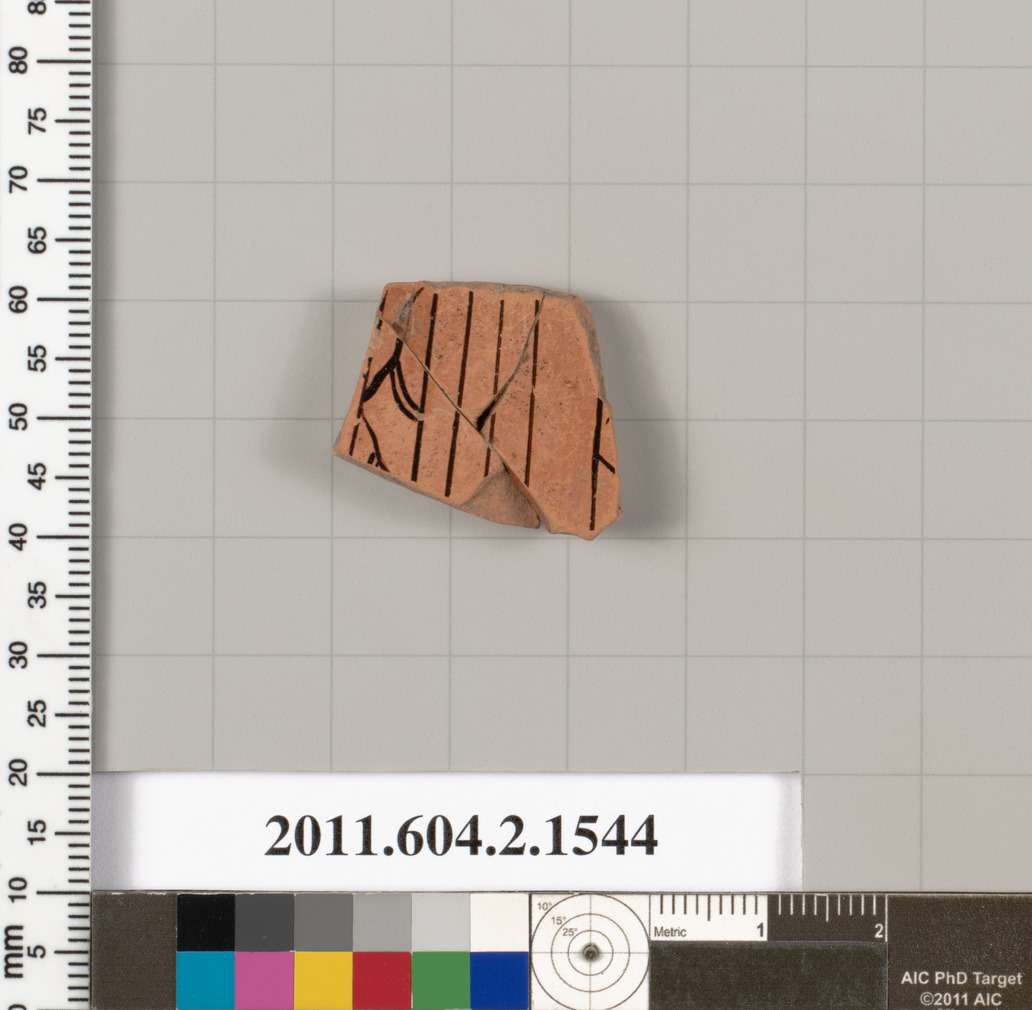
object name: skyphos fragment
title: Terracotta fragment of a skyphos (deep drinking cup)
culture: greek, attic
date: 490-480 BCE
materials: terracotta